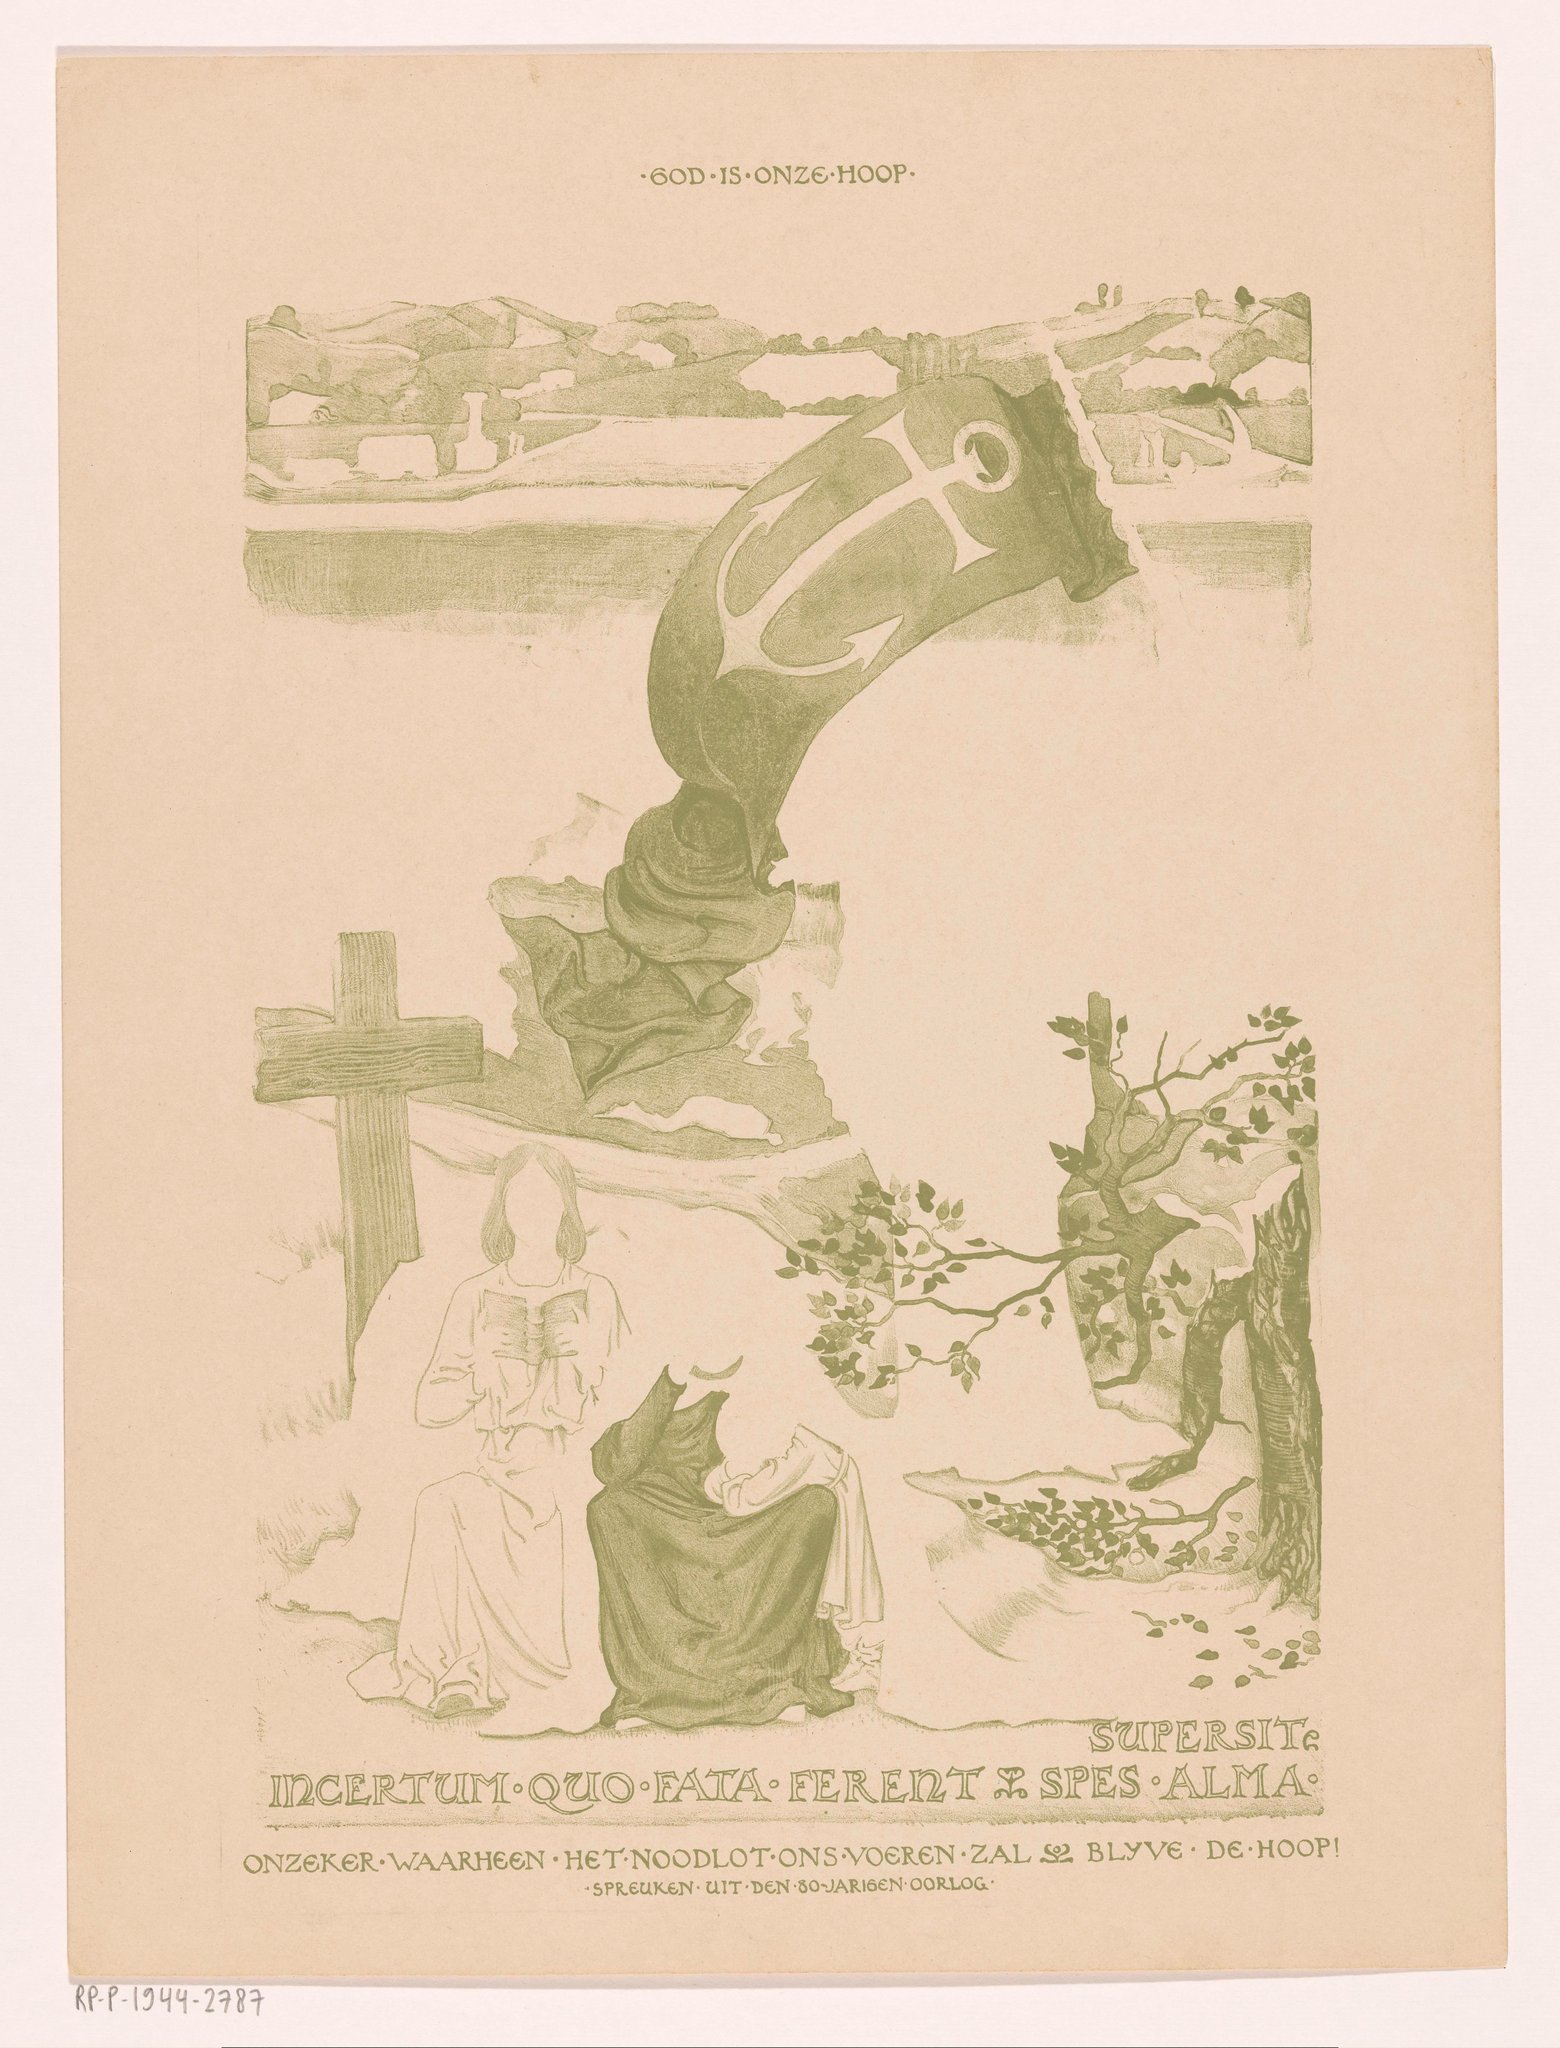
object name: print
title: Transvaalse prent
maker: antoon derkinderen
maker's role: draughtsman, painter, print maker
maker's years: 1859-1925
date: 1902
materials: paper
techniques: lithograph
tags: the cross ~ symbols of christ, hope; 'speranza', 'speranza delle fatiche' (ripa), mother and baby or young child, war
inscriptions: collector's mark: Lugt 2228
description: Een vrouw met een kind in haar armen houdt een vaandel vast waarop een anker, symbool van de hoop, staat. Ze bevindt zich in een verwoest en brandend gebied. Aan haar voeten ligt een afgeknapte boom met vruchten. Links op de voorgrond zit een groep vrouwen gehurkt voor een kruis. Op de achtergrond een Transvaals landschap met landbouwers. Bovenaan het opschrift 'Spes nostra Deus' (God is onze hoop), onderaan het opschrift 'Incertum quo fata ferent spes alma supersit' (onzeker is het waarheen het lot ons voeren zal, moge de hoop blijven).